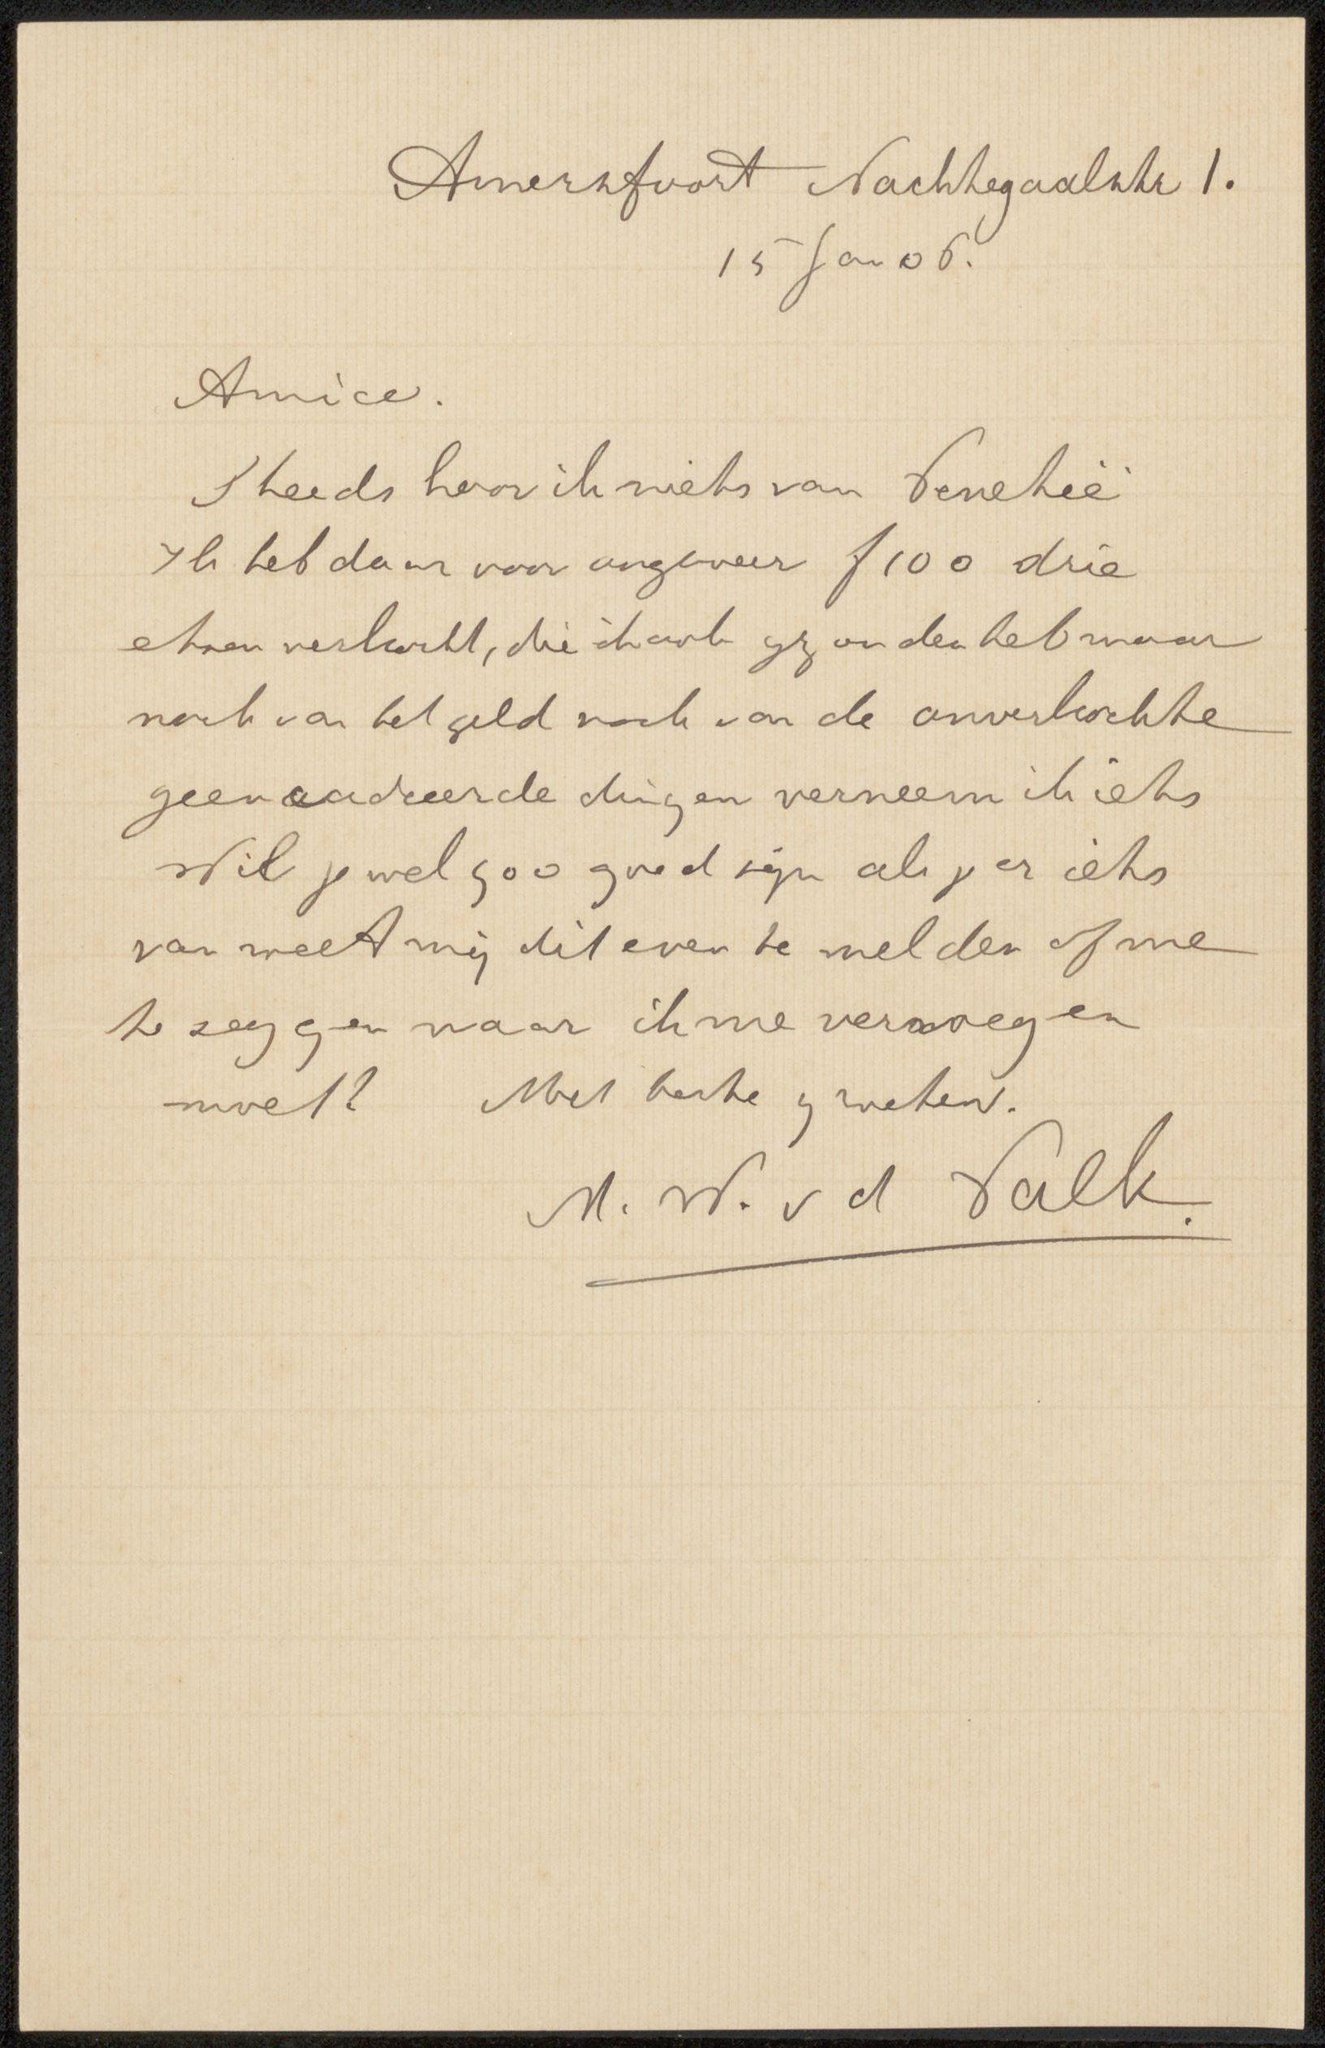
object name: letter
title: Brief aan Philip Zilcken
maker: maurits van der valk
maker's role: draughtsman, print maker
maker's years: 1857-1935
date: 1906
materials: ink, paper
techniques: pen, writing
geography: amersfoort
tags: the hague, painter, draughtsman, philip zilcken, the graphic arts, money, venice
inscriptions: collector's mark: ‘RPK’